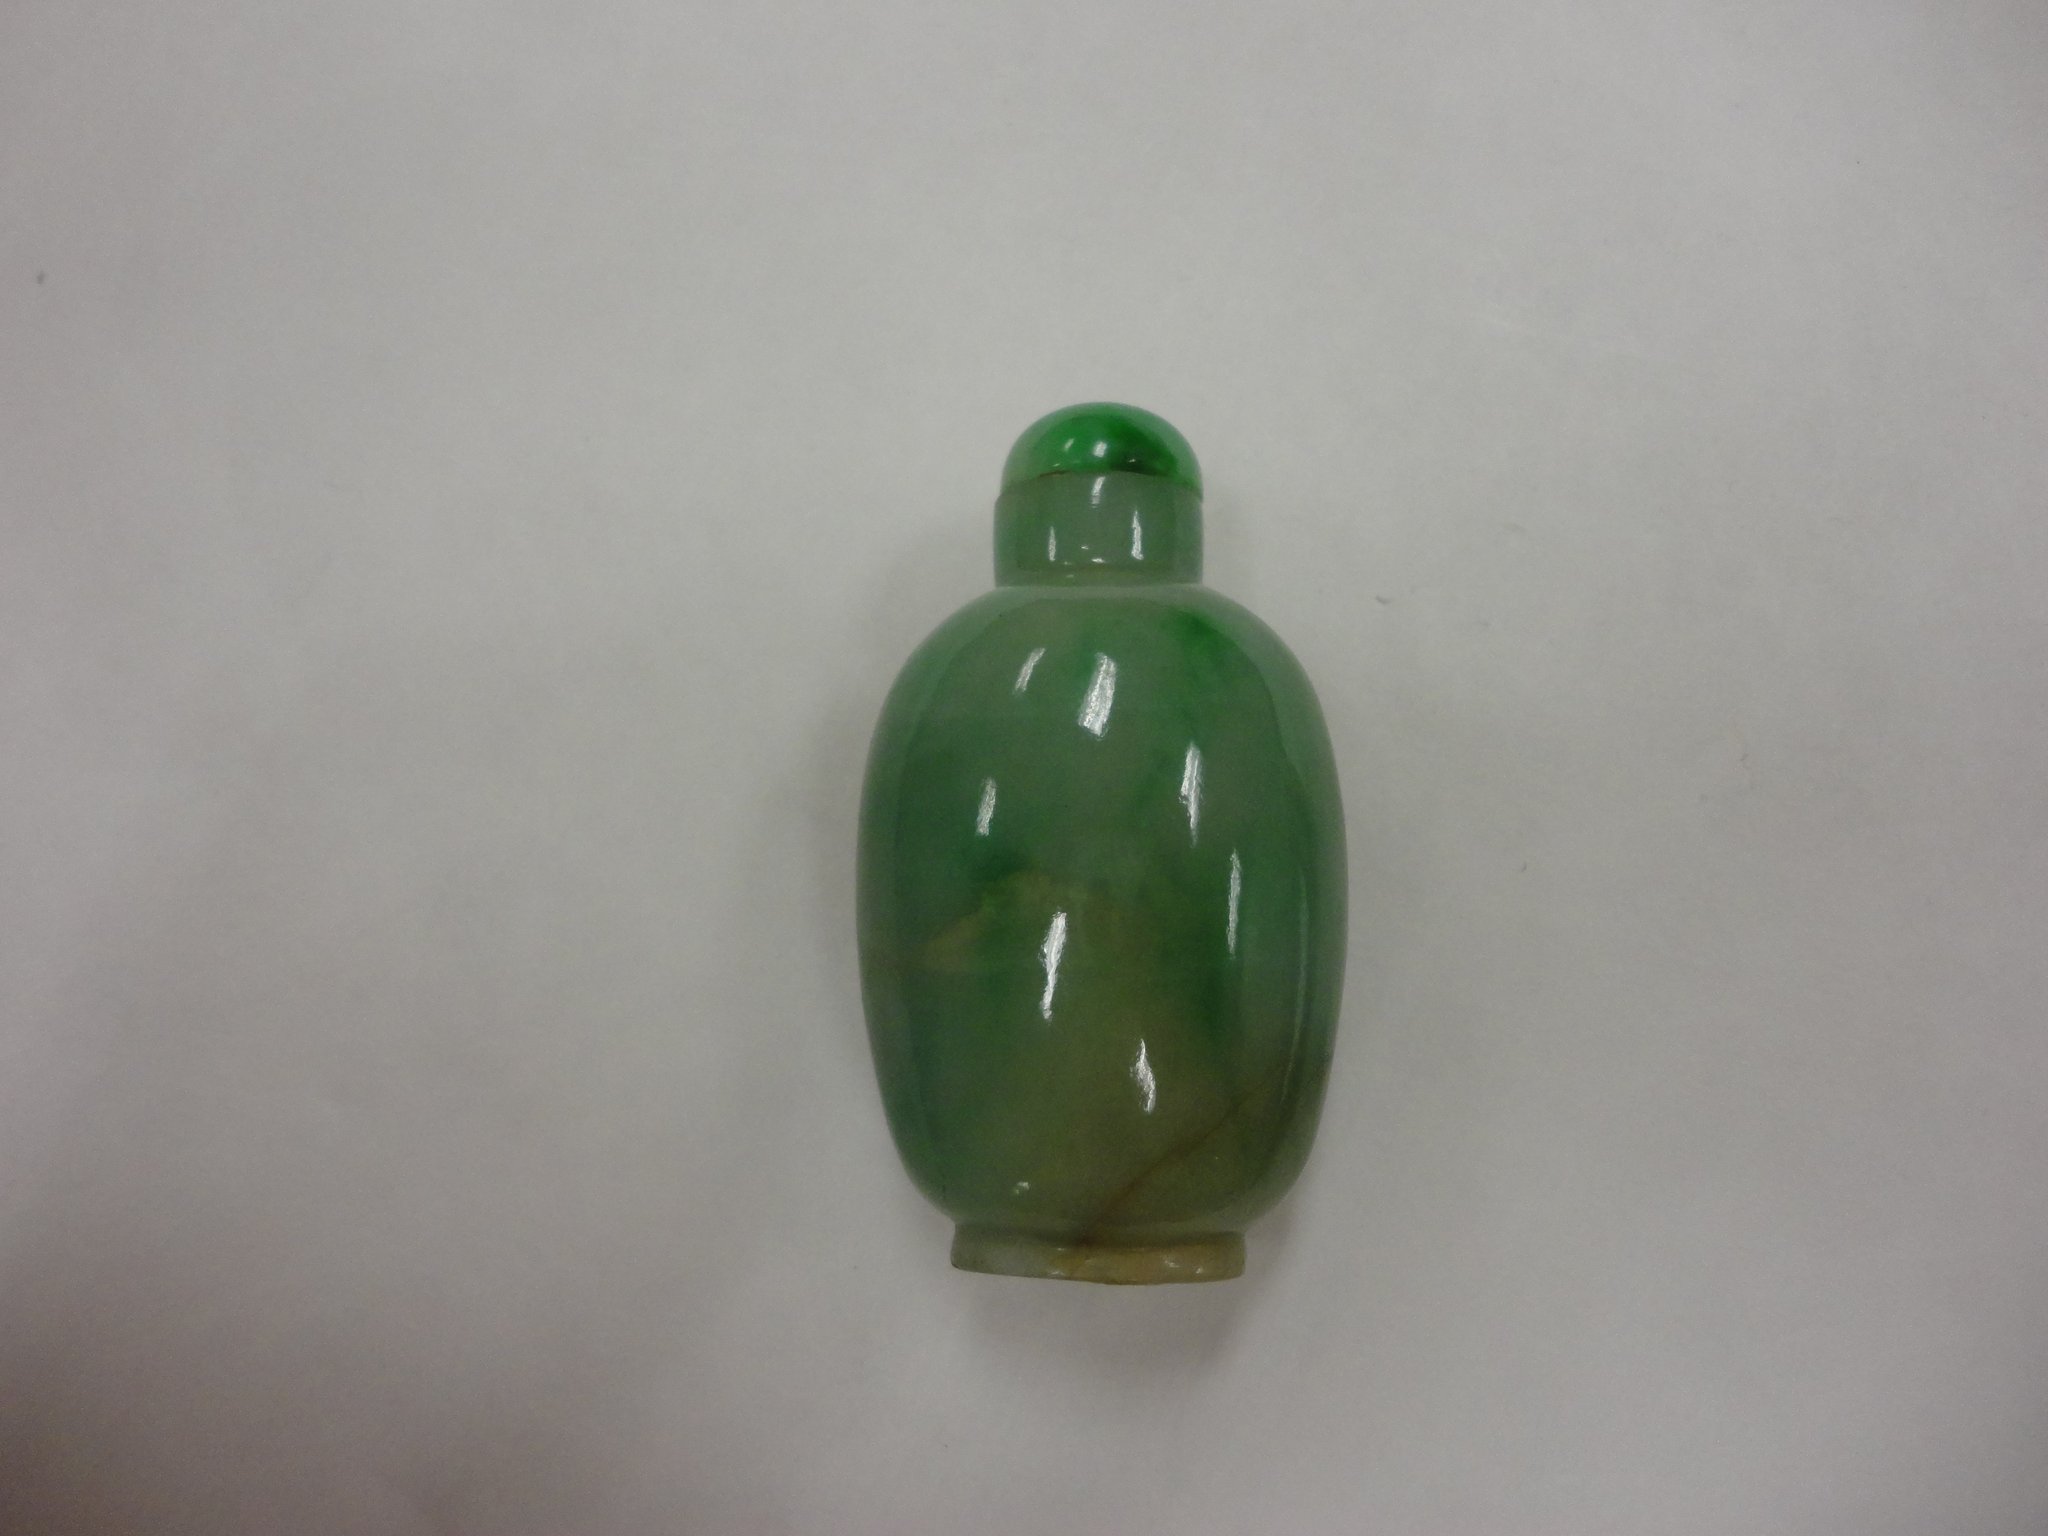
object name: snuff bottle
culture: chinese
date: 1801-1900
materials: jade